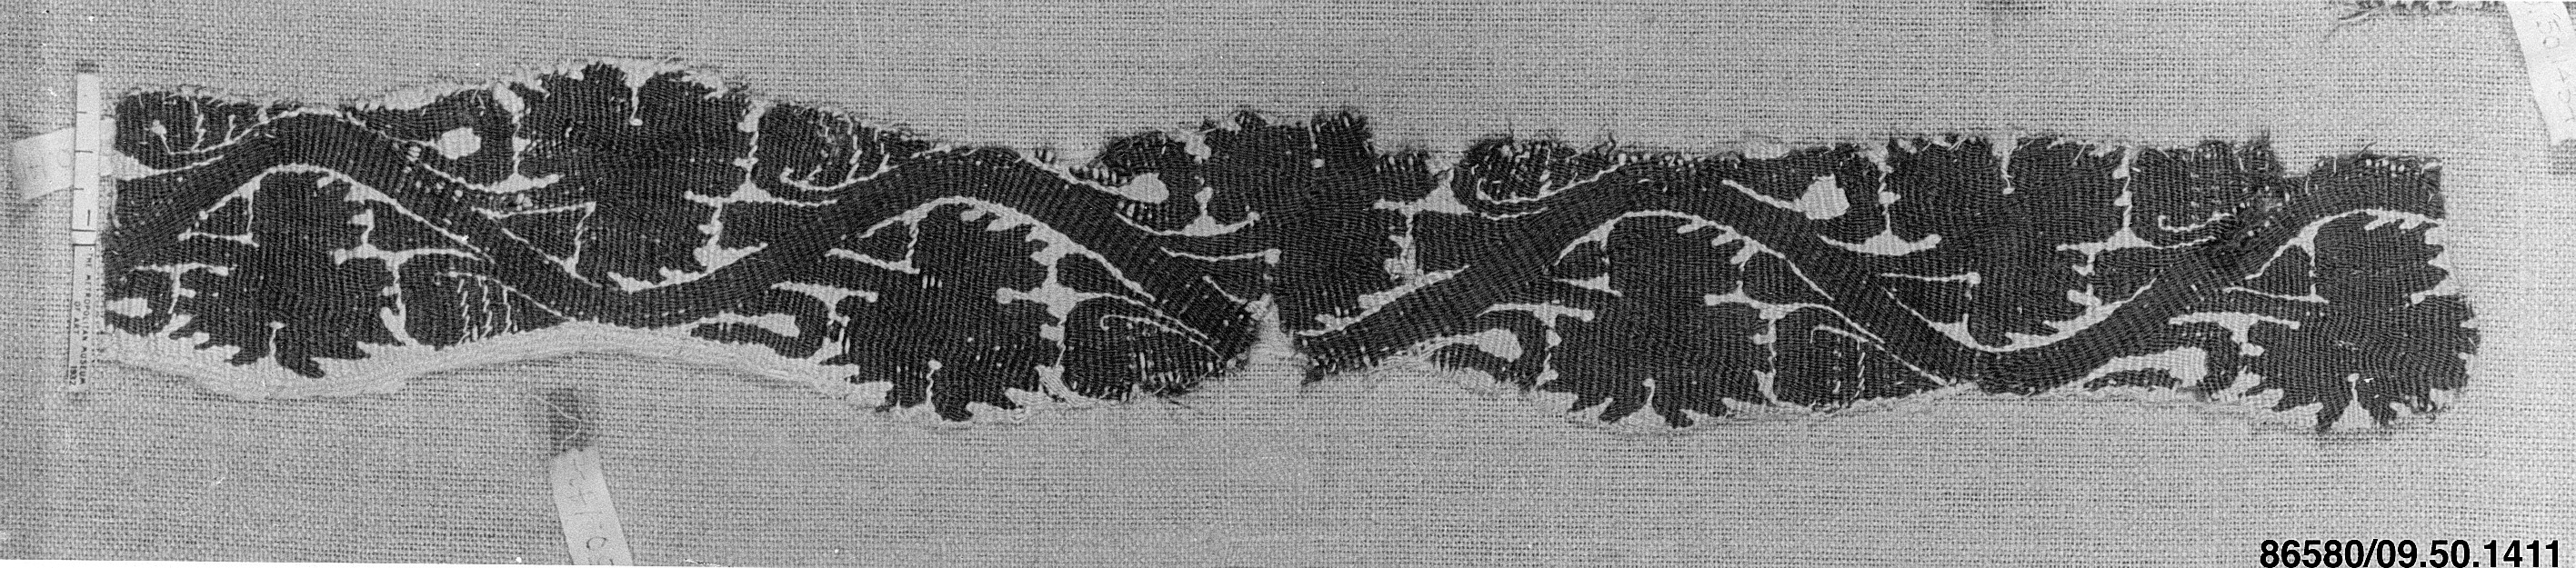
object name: band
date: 201-400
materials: linen, wool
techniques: weave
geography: egypt